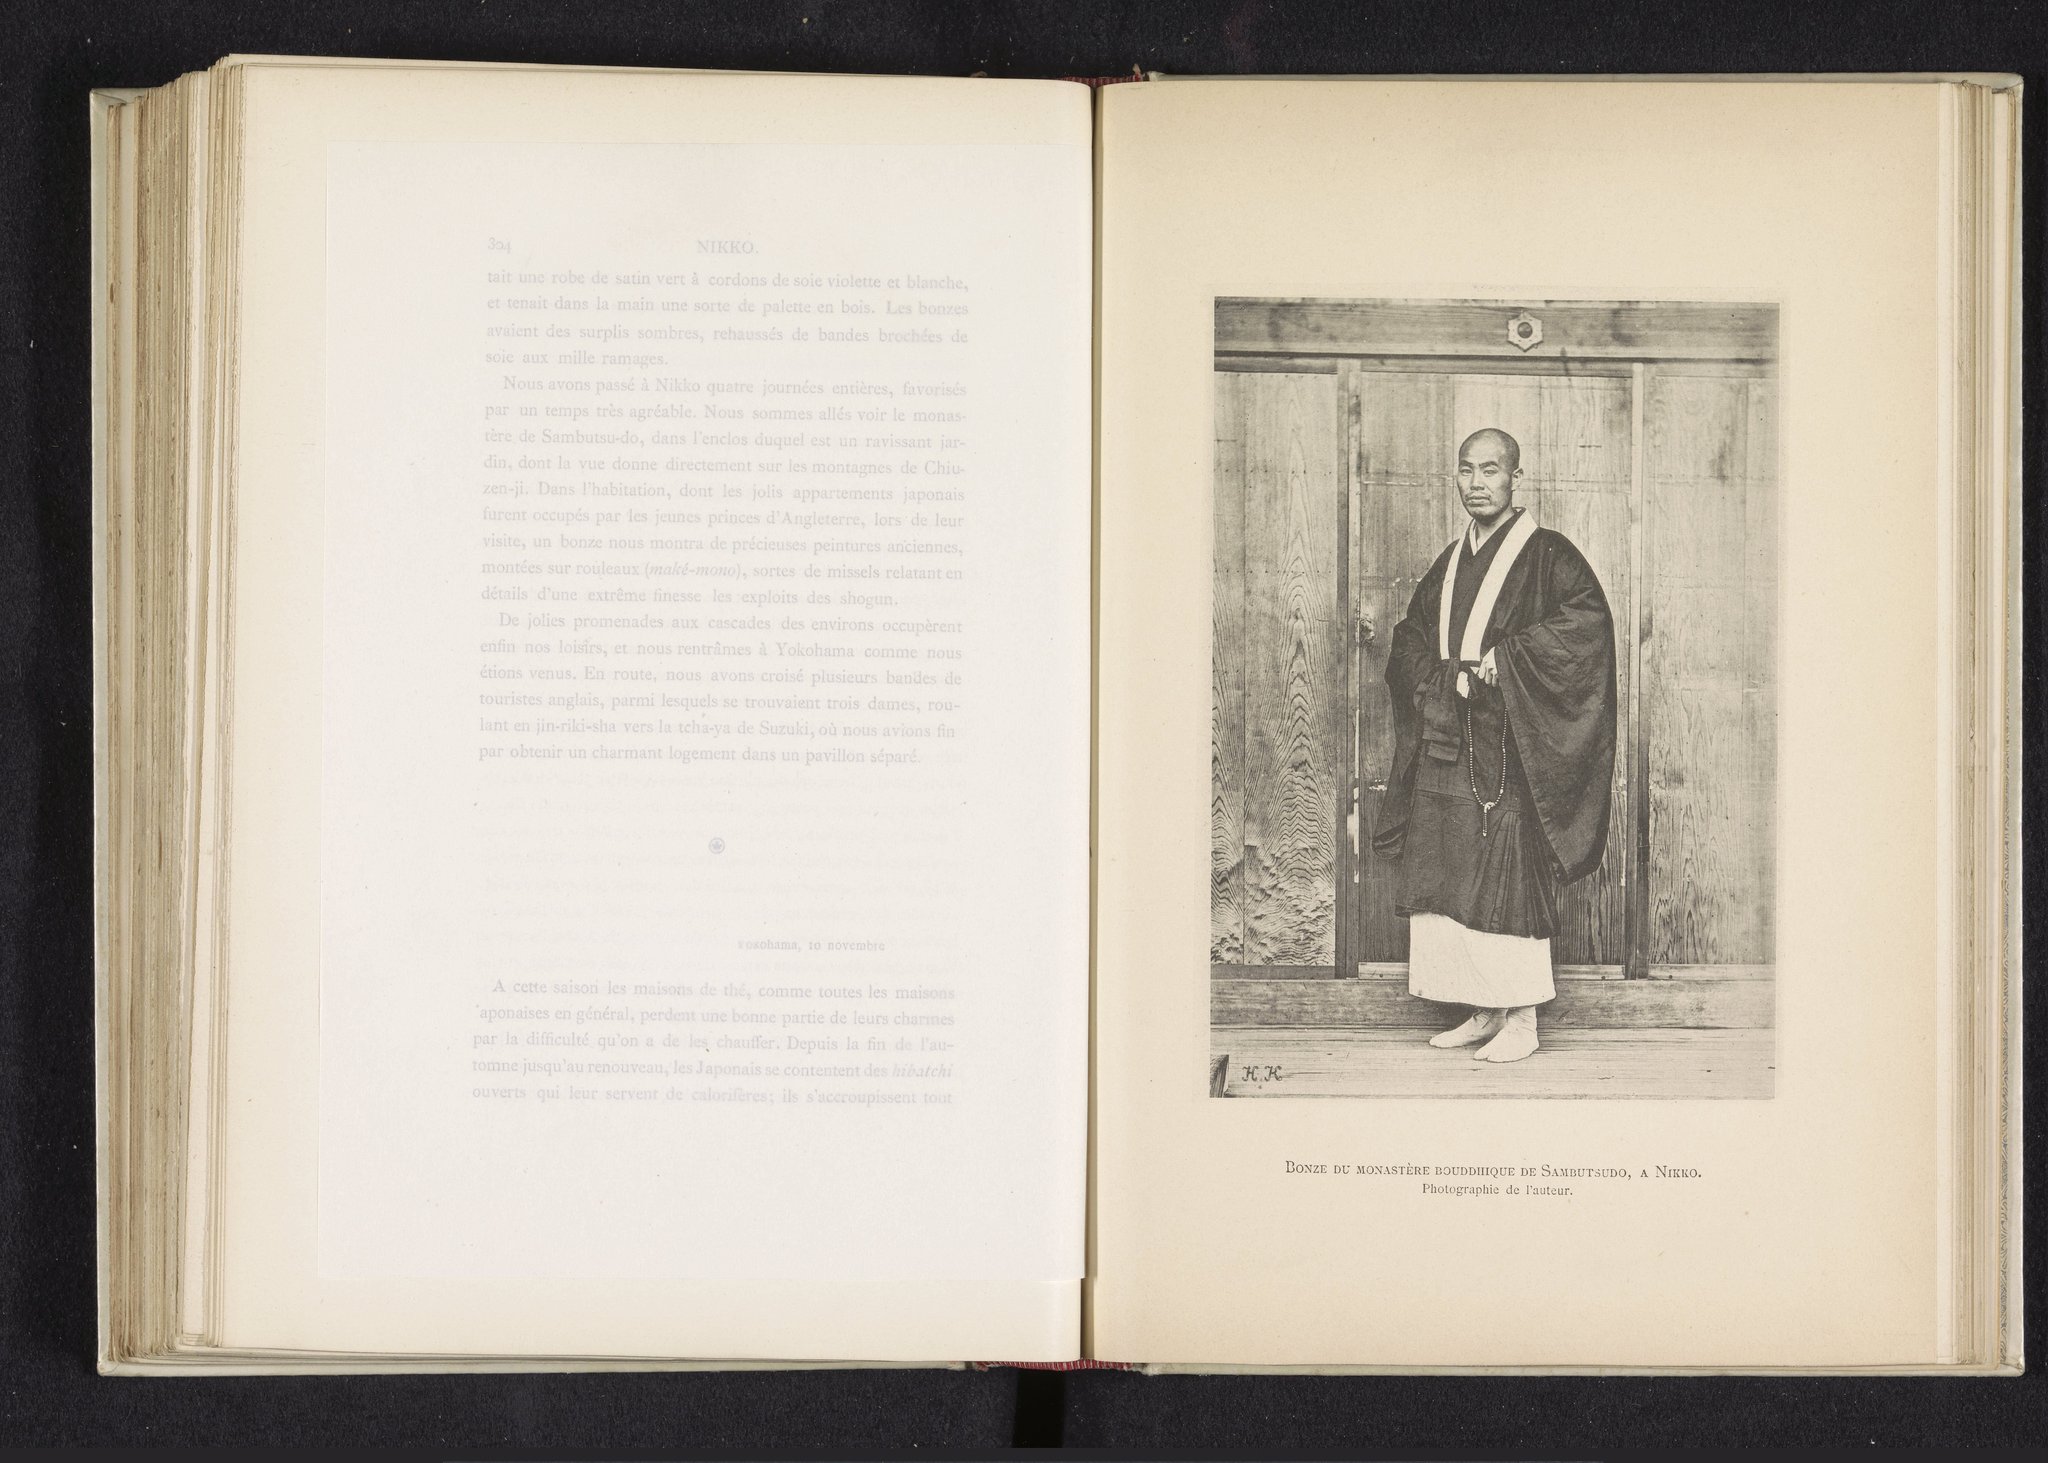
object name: photomechanical print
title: Bonze du monastère bouddhique de Sambutsudo, a Nikko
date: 1882-1883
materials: paper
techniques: photograph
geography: rinnoji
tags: temple, shrine ~ hinduism, buddhism, jainism, monk(s), friar(s), religious functionaries ~ hinduism, buddhism, jainism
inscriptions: inscription: ‘Photographie de l'auteur.’, inscription: ‘H. K.’